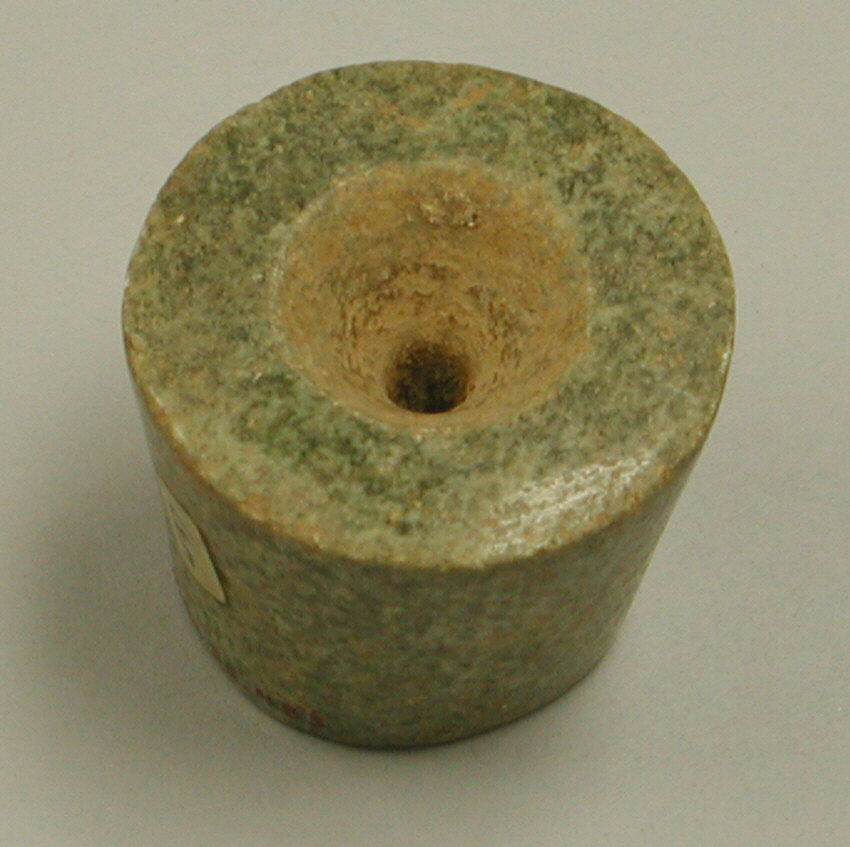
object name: earflare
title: Stone Earflare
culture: mexican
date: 1501-1600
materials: stone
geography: mexico